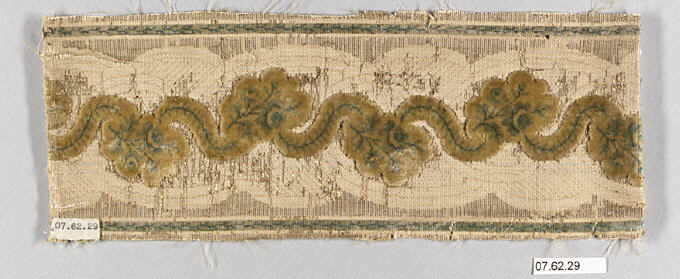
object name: ribbon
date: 1701-1800